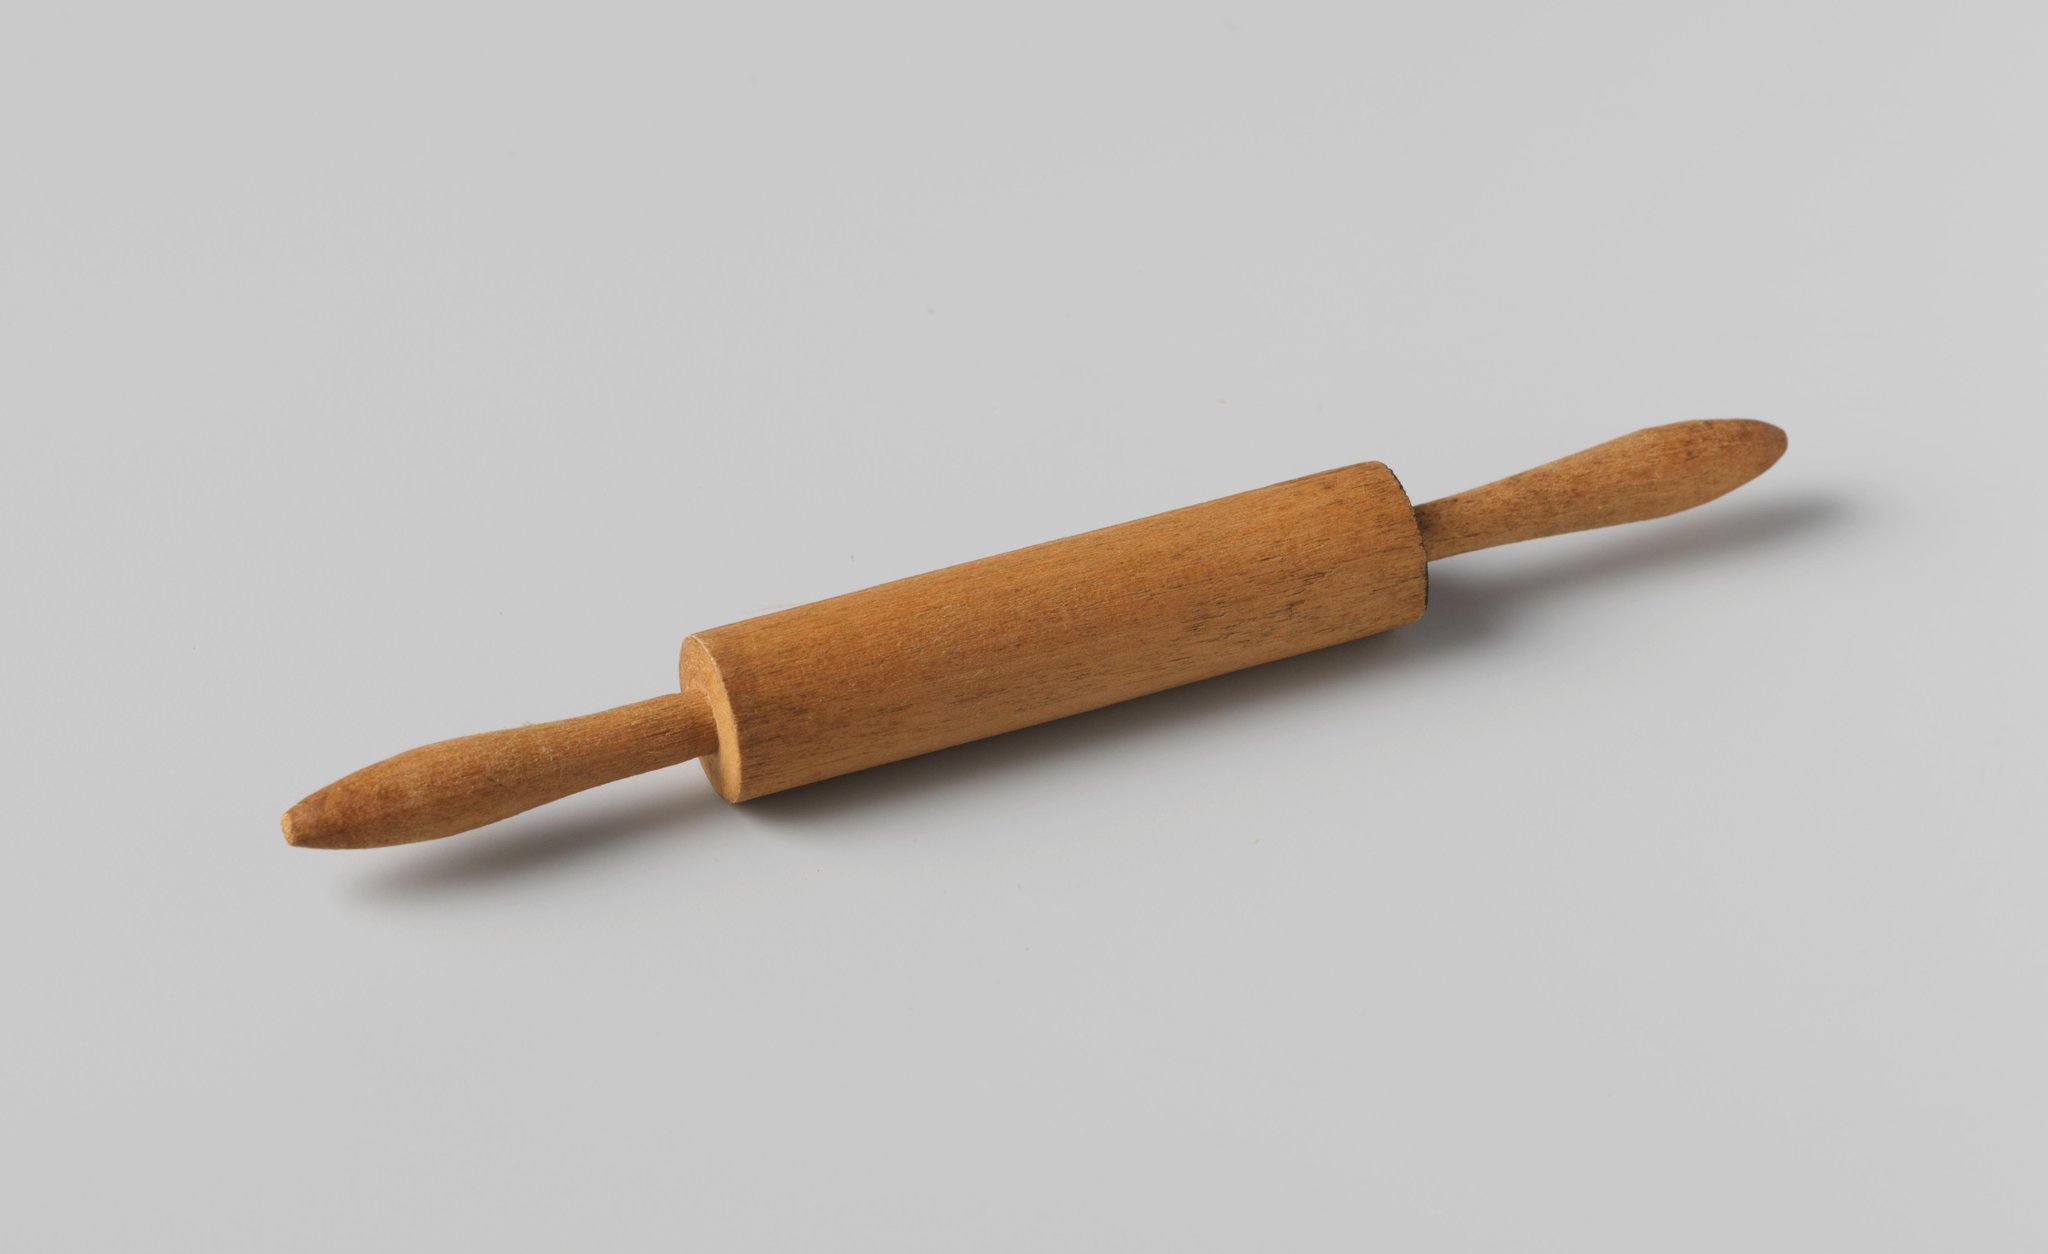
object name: rolling pin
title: Deegroller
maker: Anonymous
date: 1700-1799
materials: without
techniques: without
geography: amsterdam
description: Deegroller met lange handgrepen gemaakt van inheemse houtsoort.